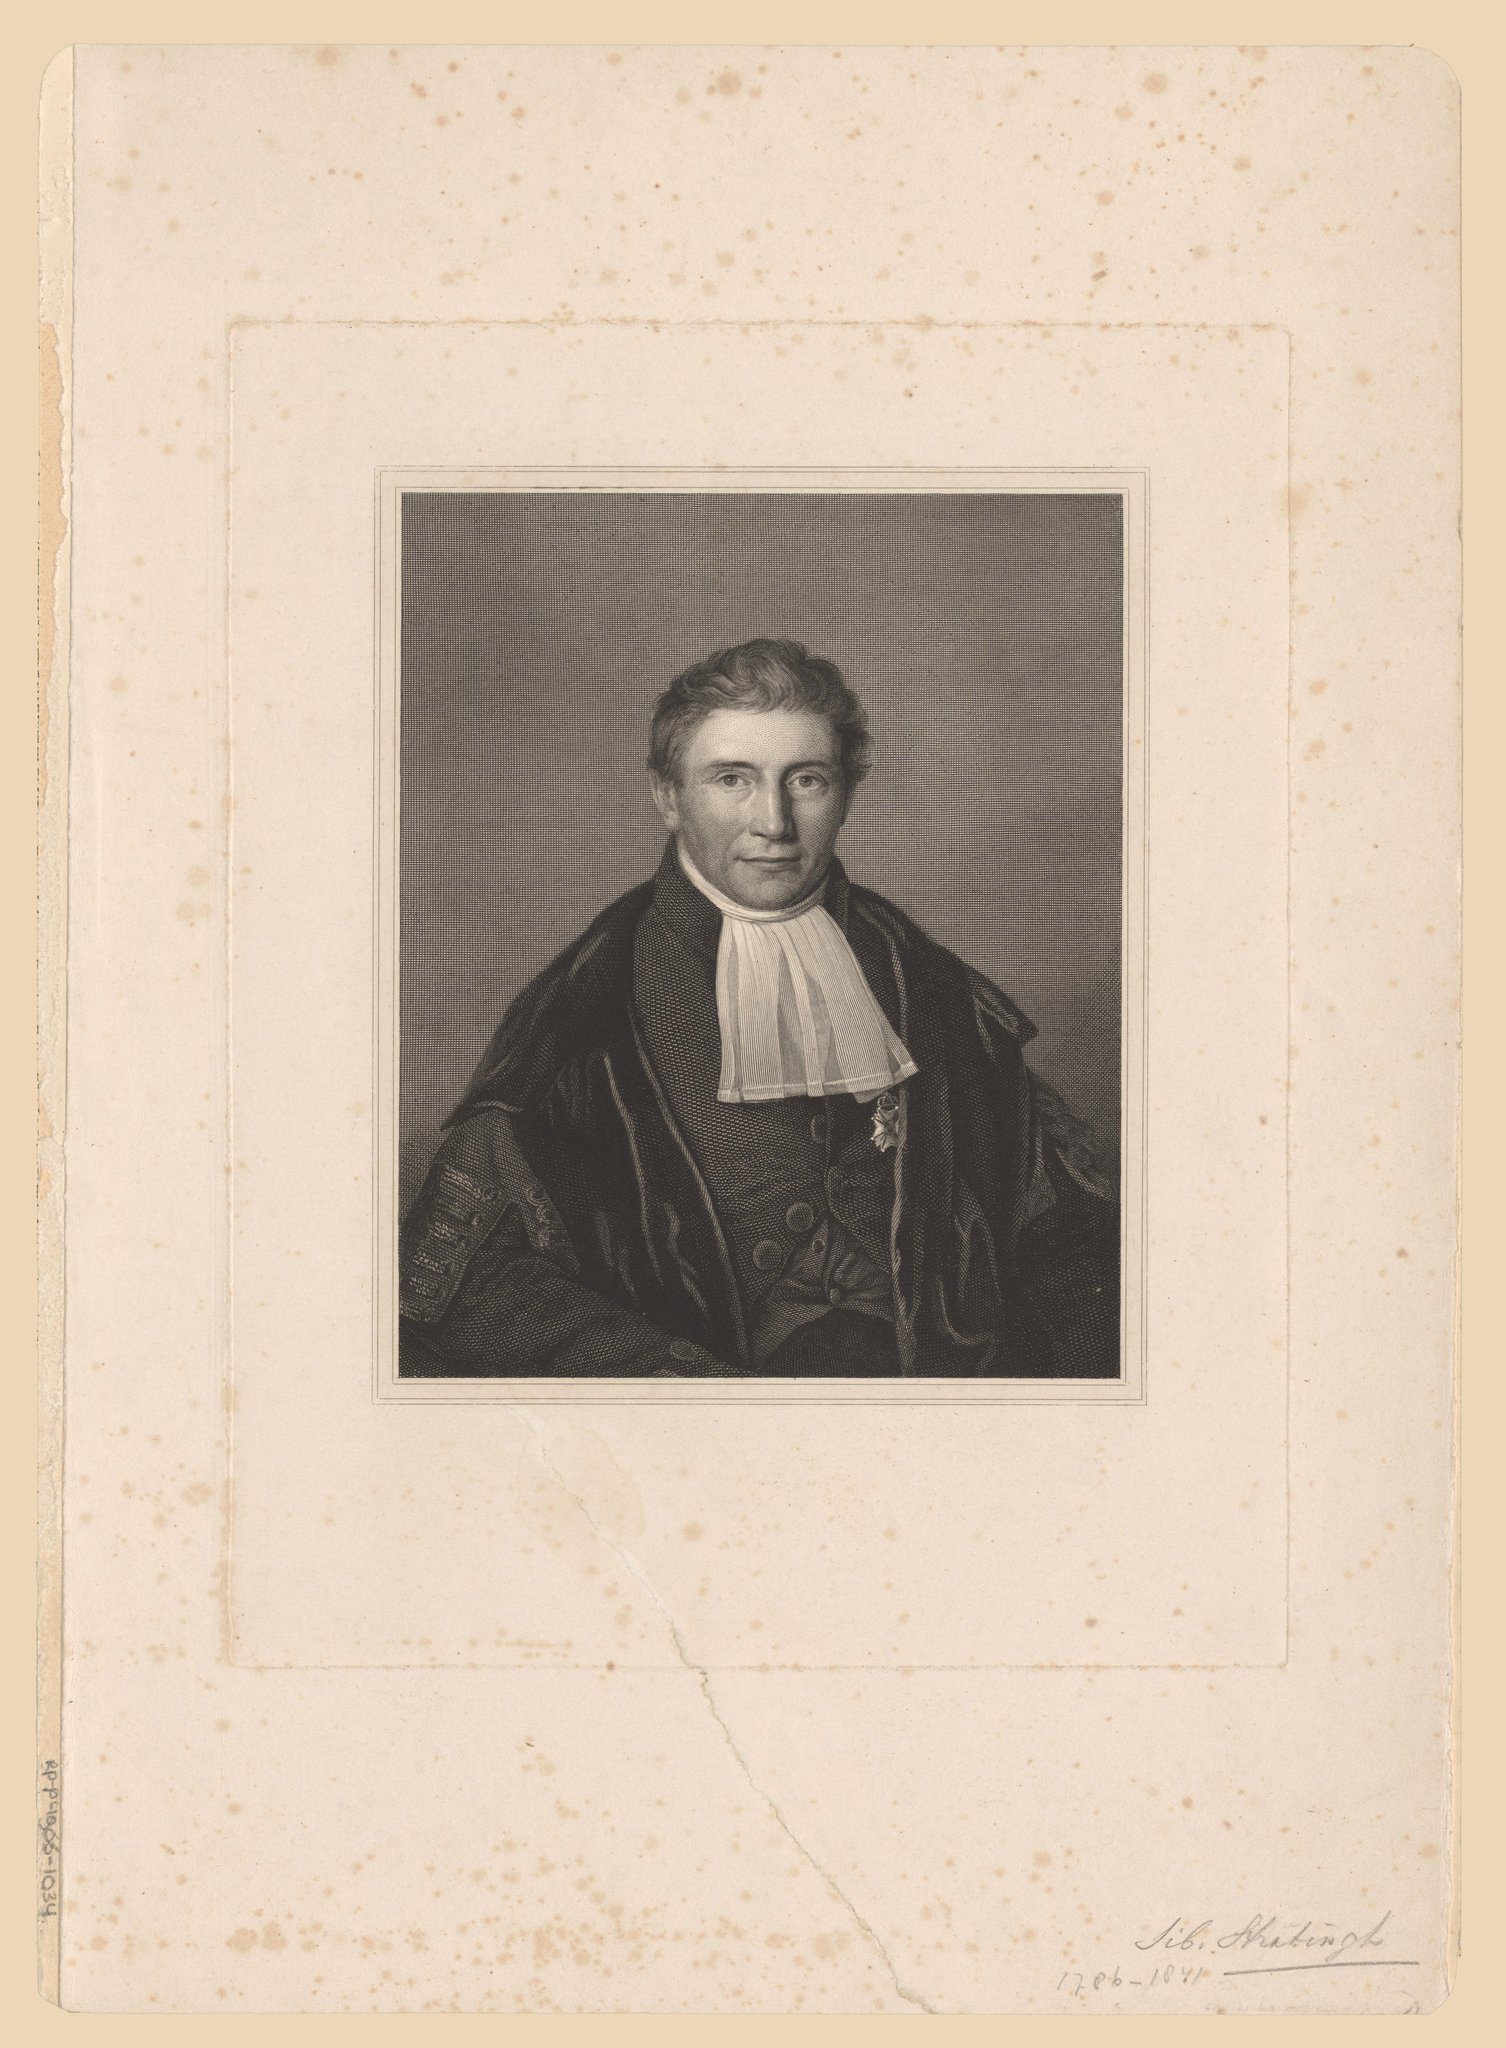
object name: print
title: Portret van Sibrandus Stratingh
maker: johannes philippus lange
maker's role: print maker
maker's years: 1810-1849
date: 1833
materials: paper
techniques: engraving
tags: chemistry (+ portrait of scholar, scientist), historical persons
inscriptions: collector's mark: Lugt 2228